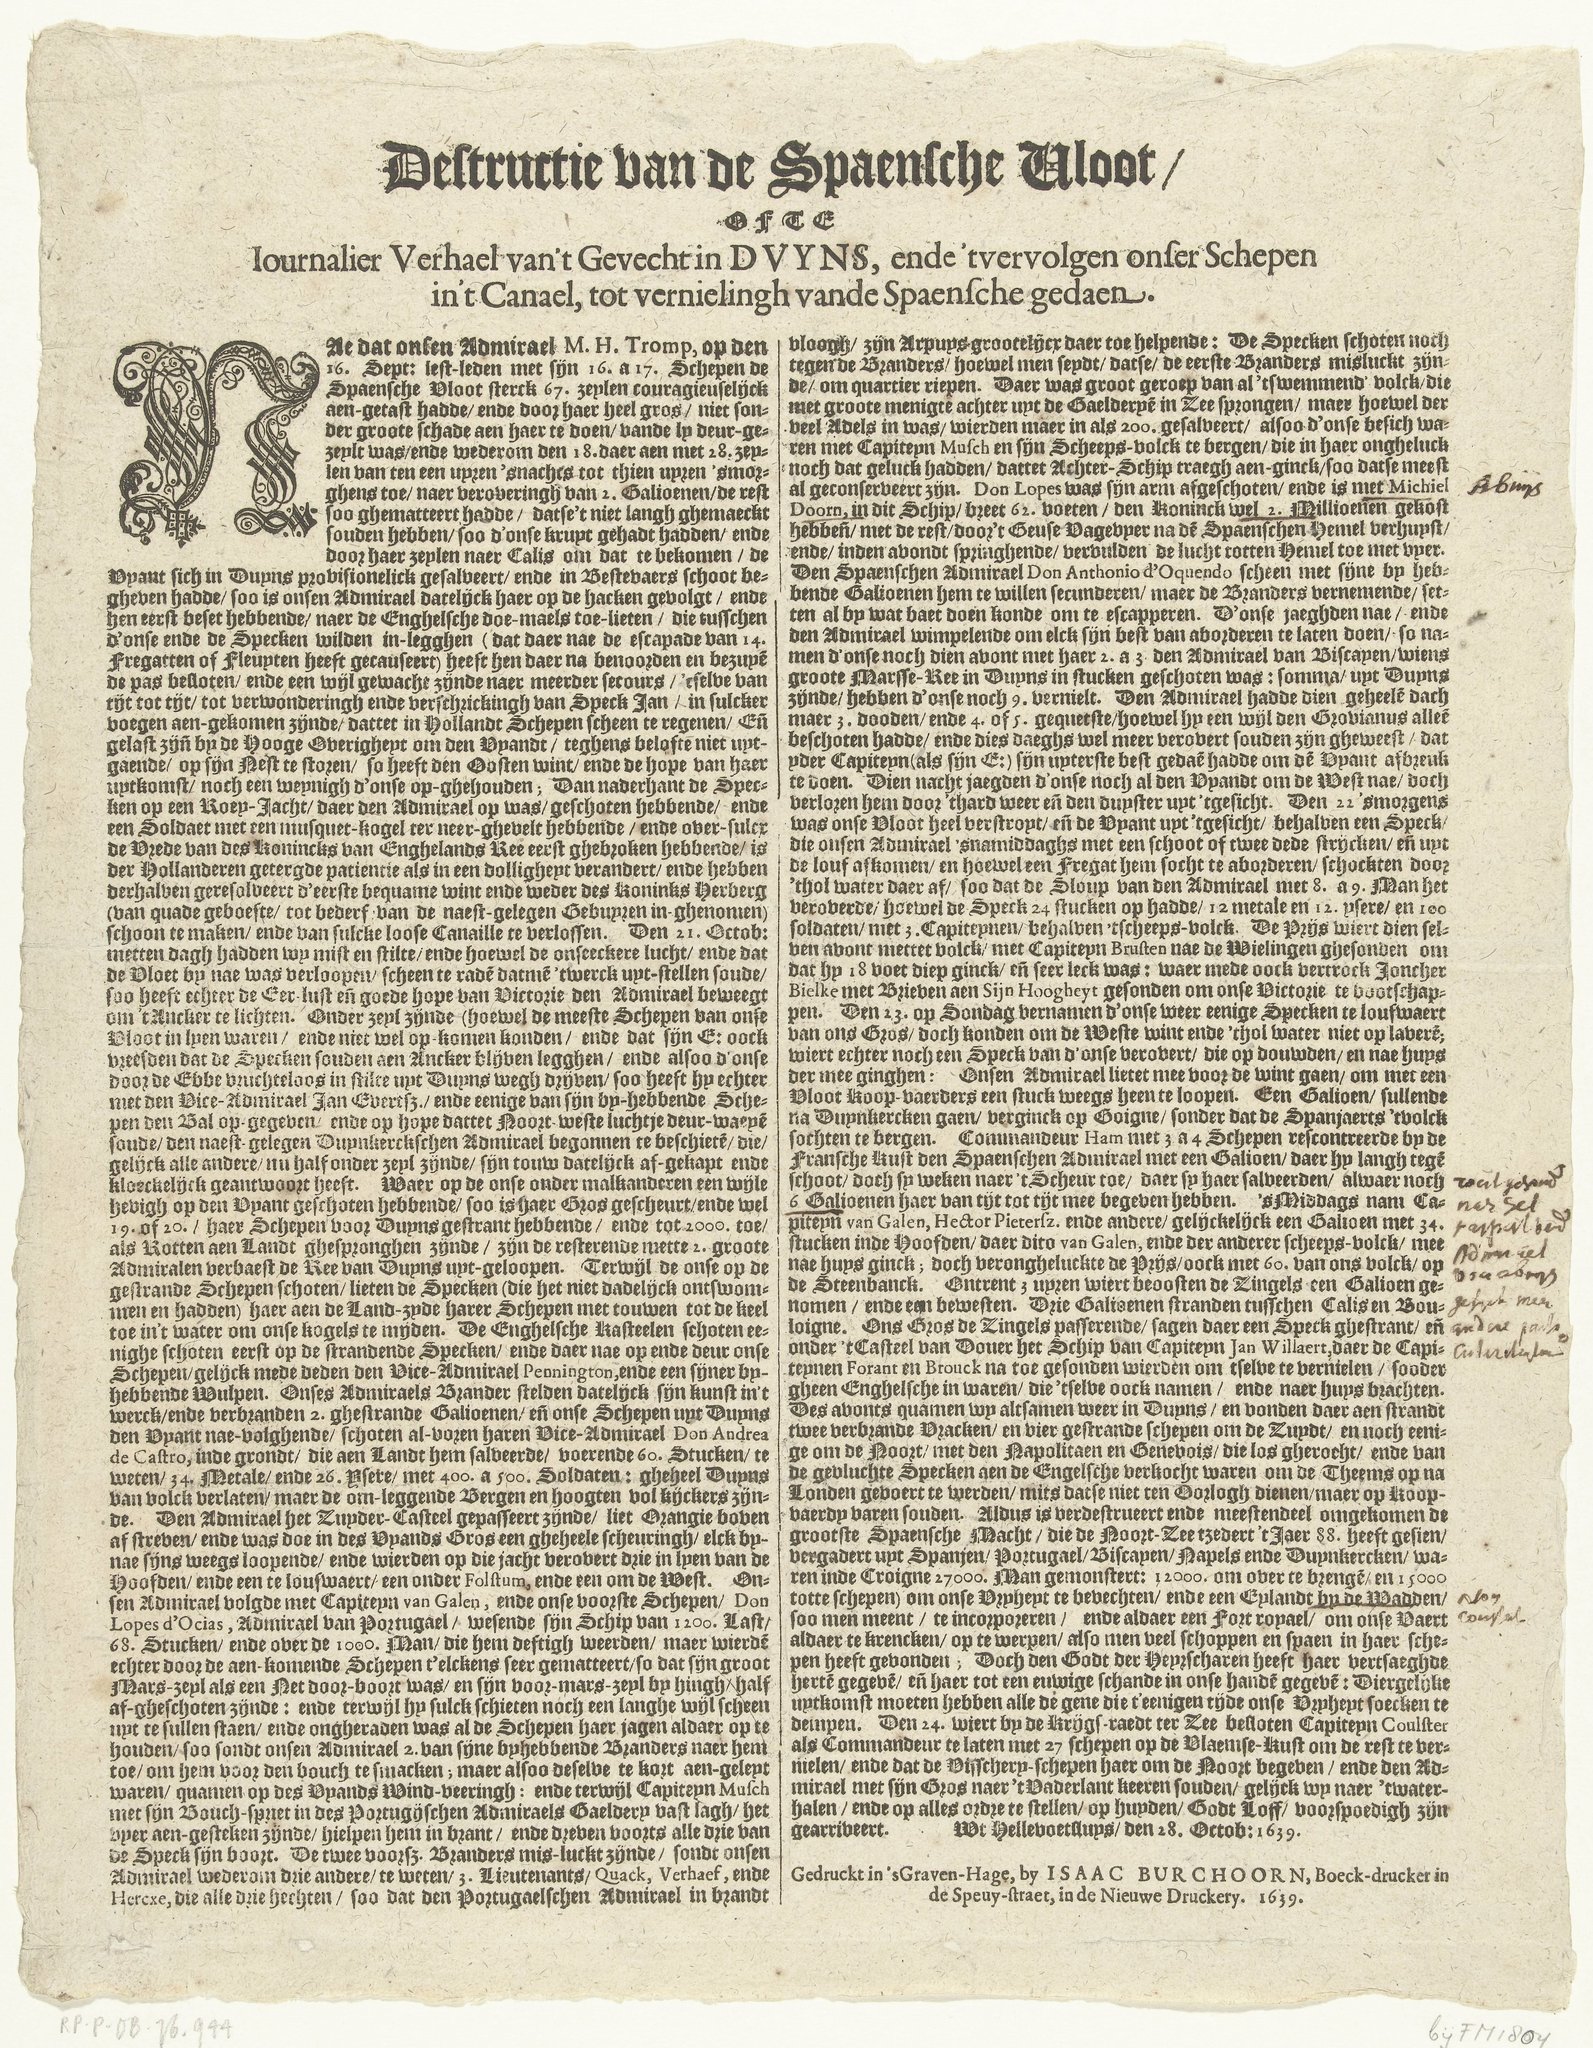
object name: text sheet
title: Brief van de overwinning in de zeeslag bij Duins, gedrukt als een pamflet, 1639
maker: isaac burghoorn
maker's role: printer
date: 1639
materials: paper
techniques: letterpress printing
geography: the hague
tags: brielle, maarten harpertszoon tromp, battle of the downs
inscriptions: date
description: Pamflet in de vorm van een brief van de overwinning in de zeeslag bij Duins tussen de Spaanse vloot onder bevel van Antonio de Oquendo en de Staatse vloot onder Maarten Harpertsz. Tromp, 21 oktober 1639. Tekst in 2 kolommen, afgesloten met: Hellevoetsluis / 28 oktober 1639. In de kantlijn enkele aantekeningen met de pen.